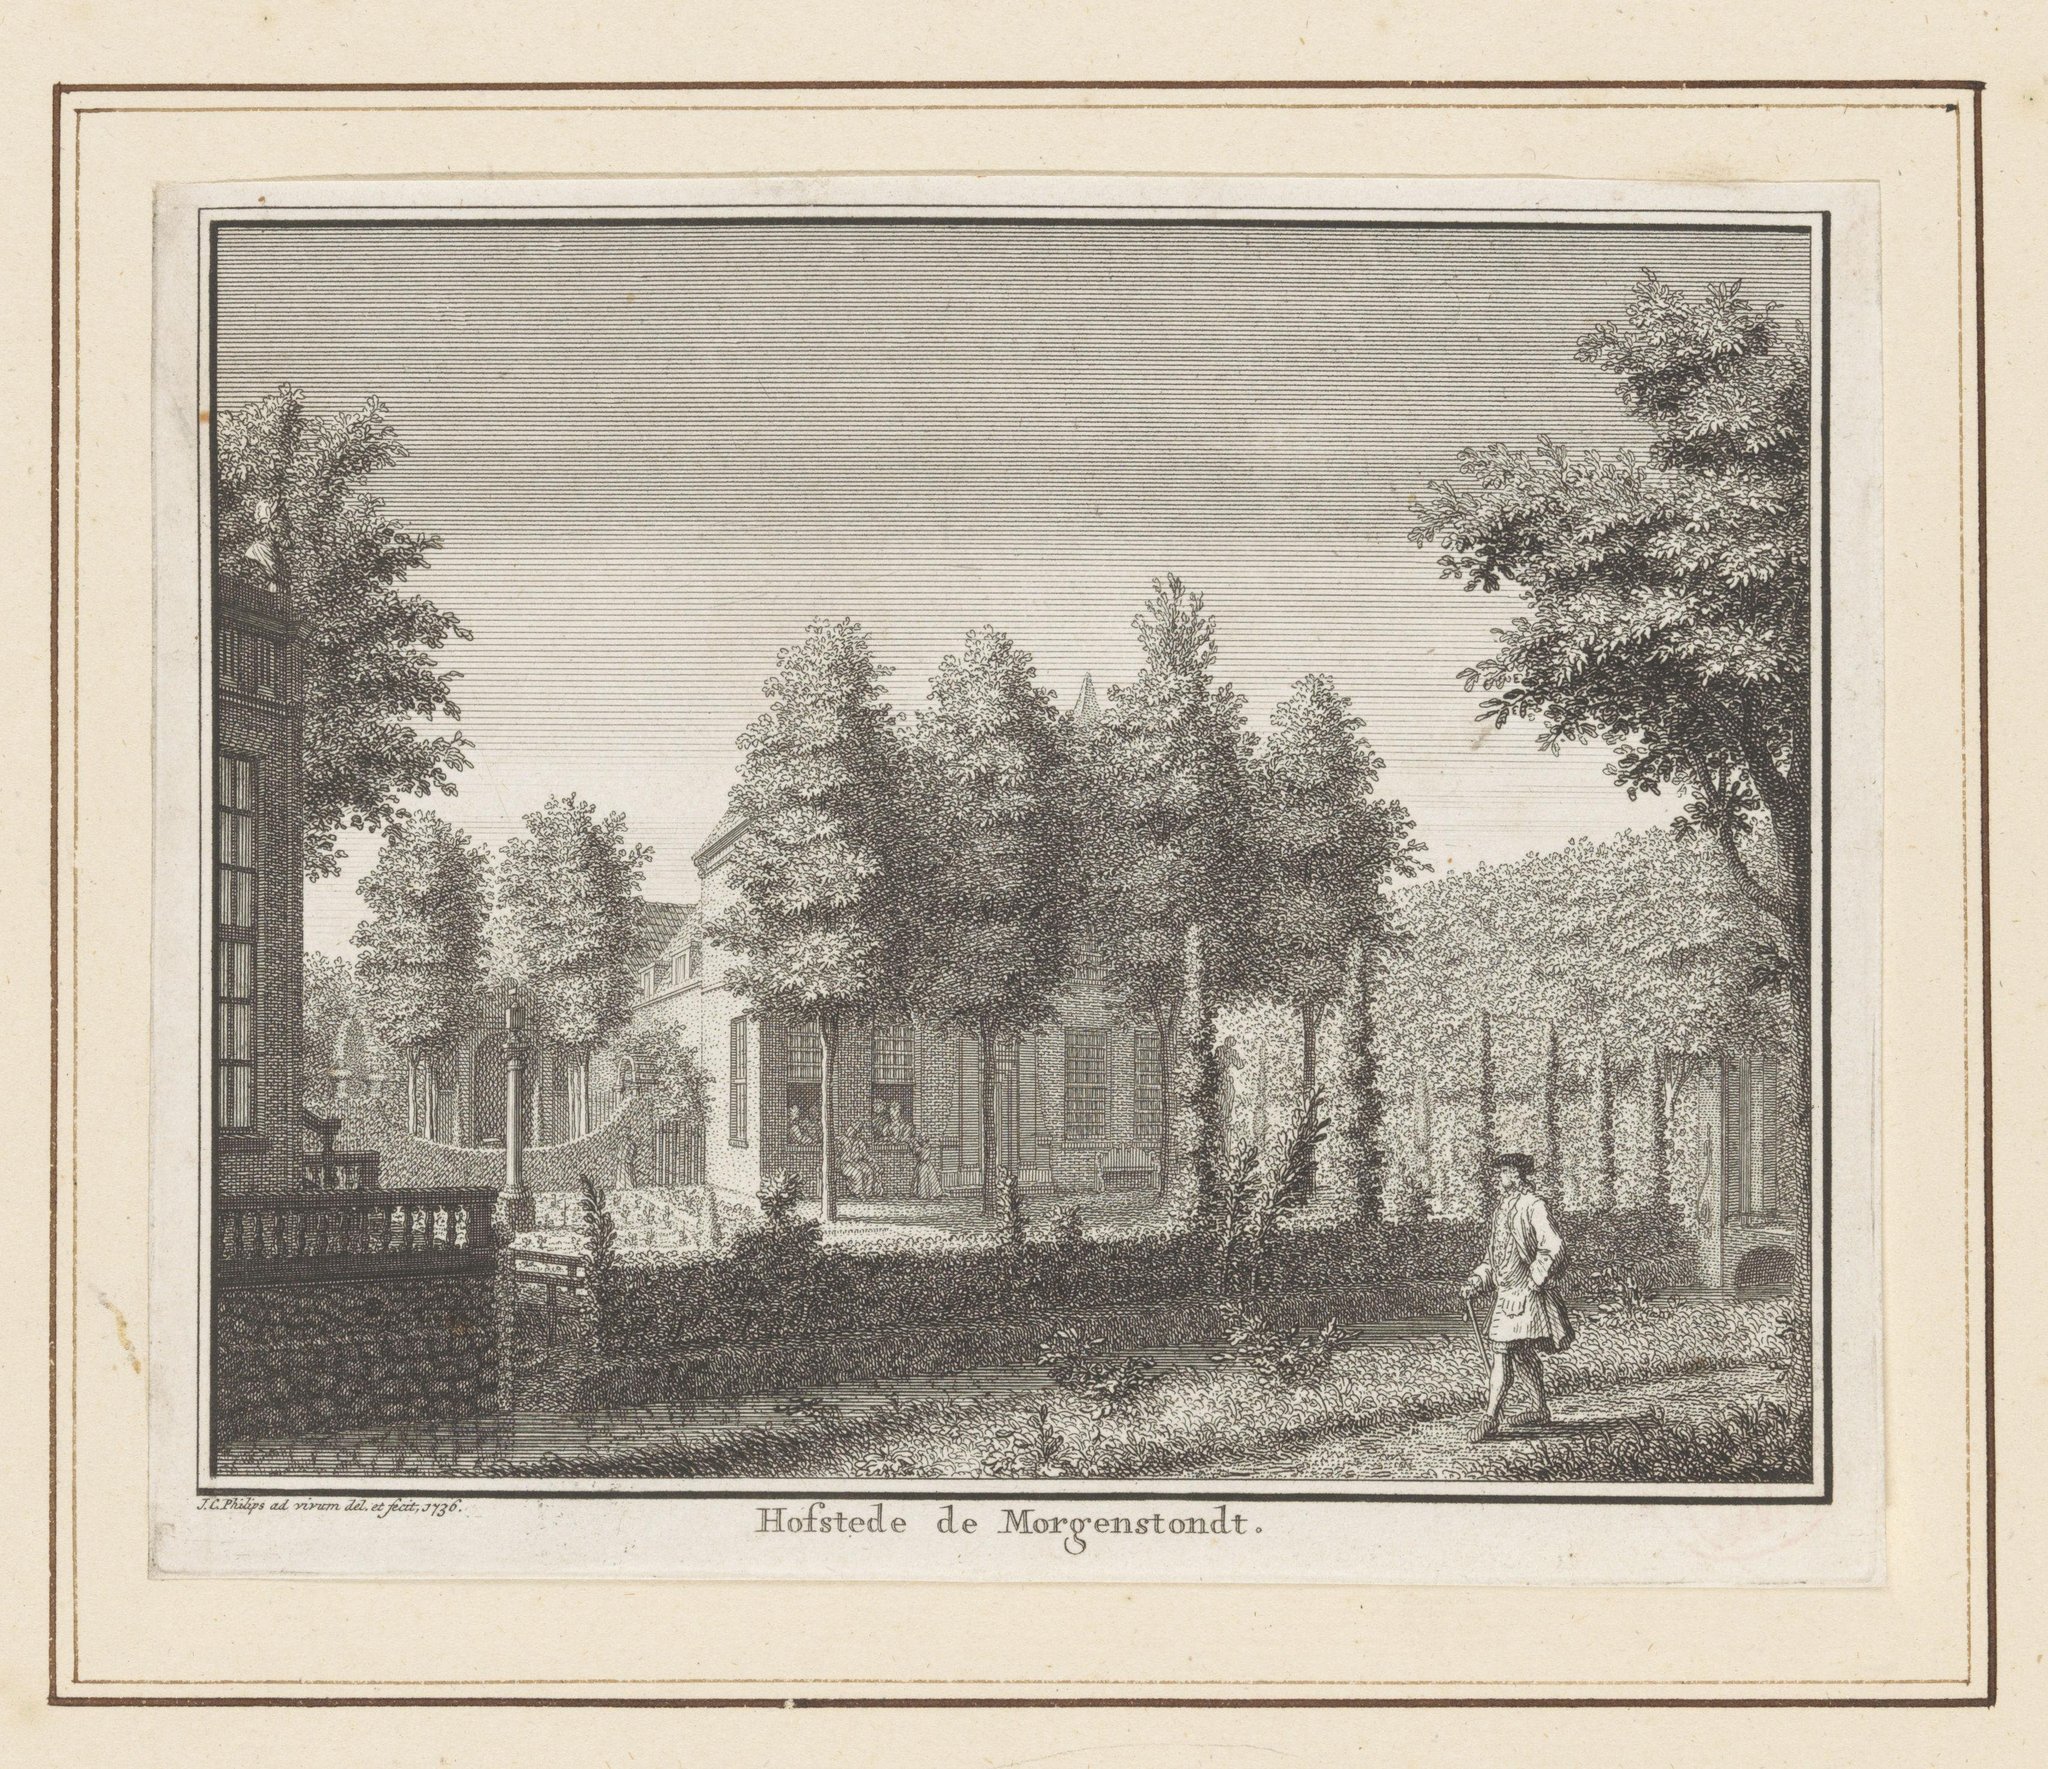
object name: print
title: Gezicht op hofstede de Morgenstond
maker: jan caspar philips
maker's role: draughtsman, print maker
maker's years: 1700-1775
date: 1736-1773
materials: paper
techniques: engraving, etching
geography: amstelveen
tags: country-house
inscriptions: collector's mark: Lugt 195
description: Prent ook gebruikt in: Schoemaker, Gerrit ed. Daniel Willinks Amstellandsche Arkadia, of beschryving van de gelegenheit, toestant en gebeurtenissen van Amstellandt, met deszelfs onderhoorige dorpen, heerlykheden, ambachten, lusthoven, wateren, enz. (…). 2 delen. 1e druk. Amsterdam: Arend van Huyssteen, 1737, dl. 1, p. 102. Of in: Schoemaker, Gerrit ed. Daniel Willinks Amstellandsche Arkadia, of beschryving van de gelegenheit, toestant en gebeurtenissen van Amstellandt, met deszelfs onderhoorige dorpen, heerlykheden, ambachten, lusthoven, wateren, enz. (…). 2 delen. 2e druk. Utrecht: Samuel de Waal, 1773, dl. 1, p. 99.